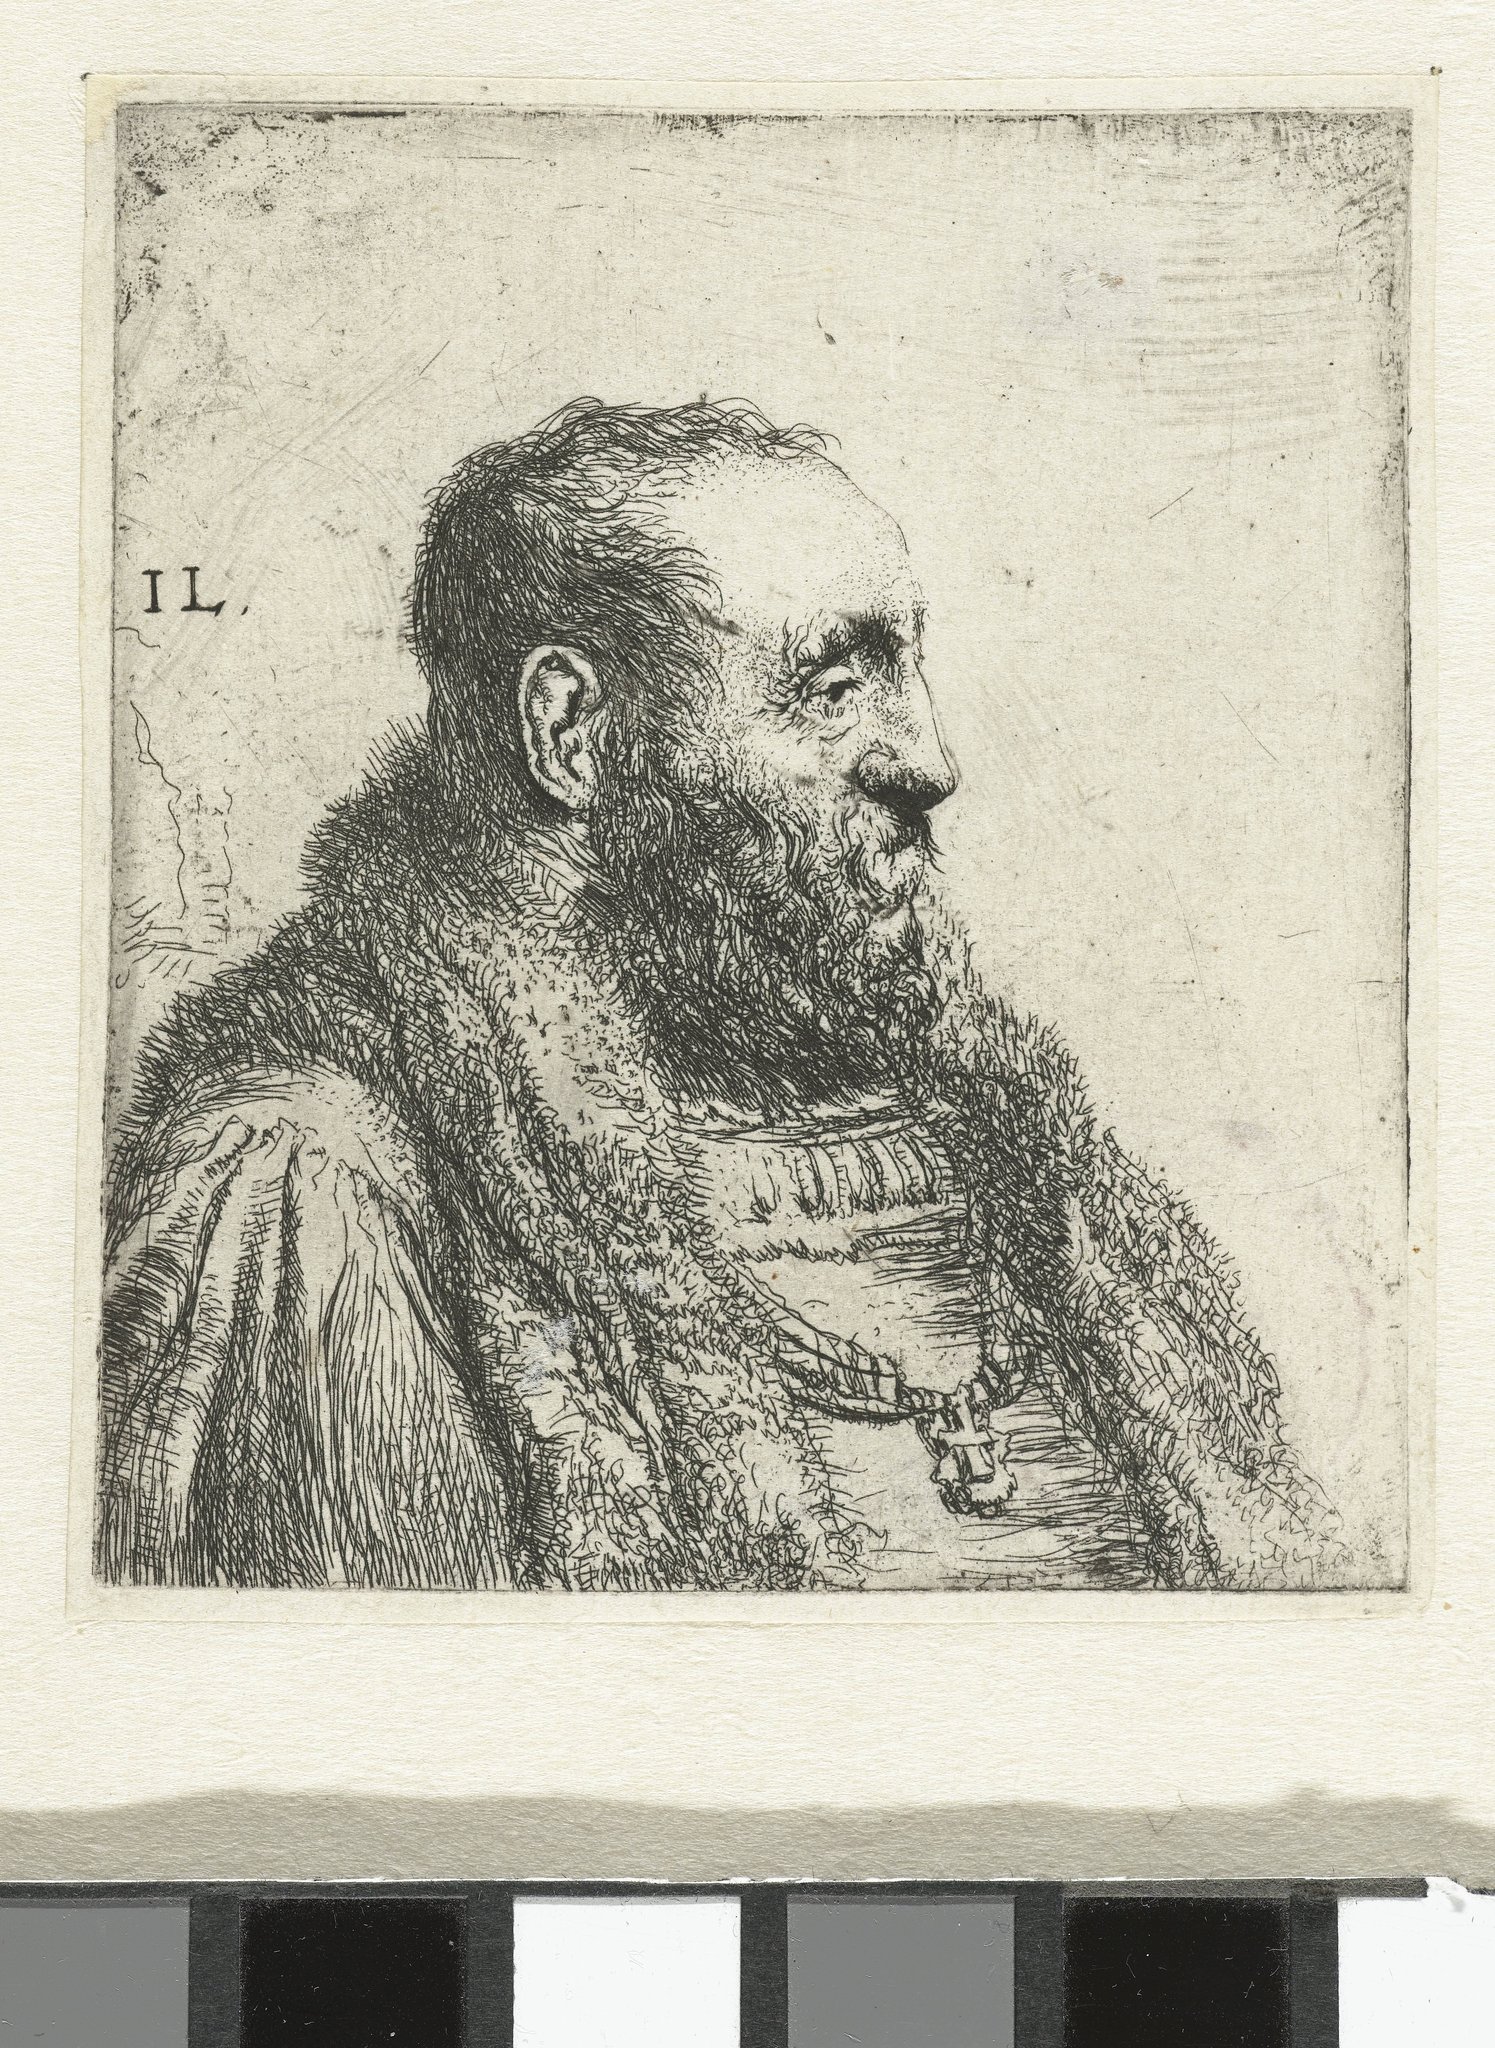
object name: print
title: Borstbeeld van een oude heer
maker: jan lievens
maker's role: draughtsman, painter, print maker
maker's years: 1607-1674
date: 1625-1674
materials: paper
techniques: etching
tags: old man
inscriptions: collector's mark: Lugt 240